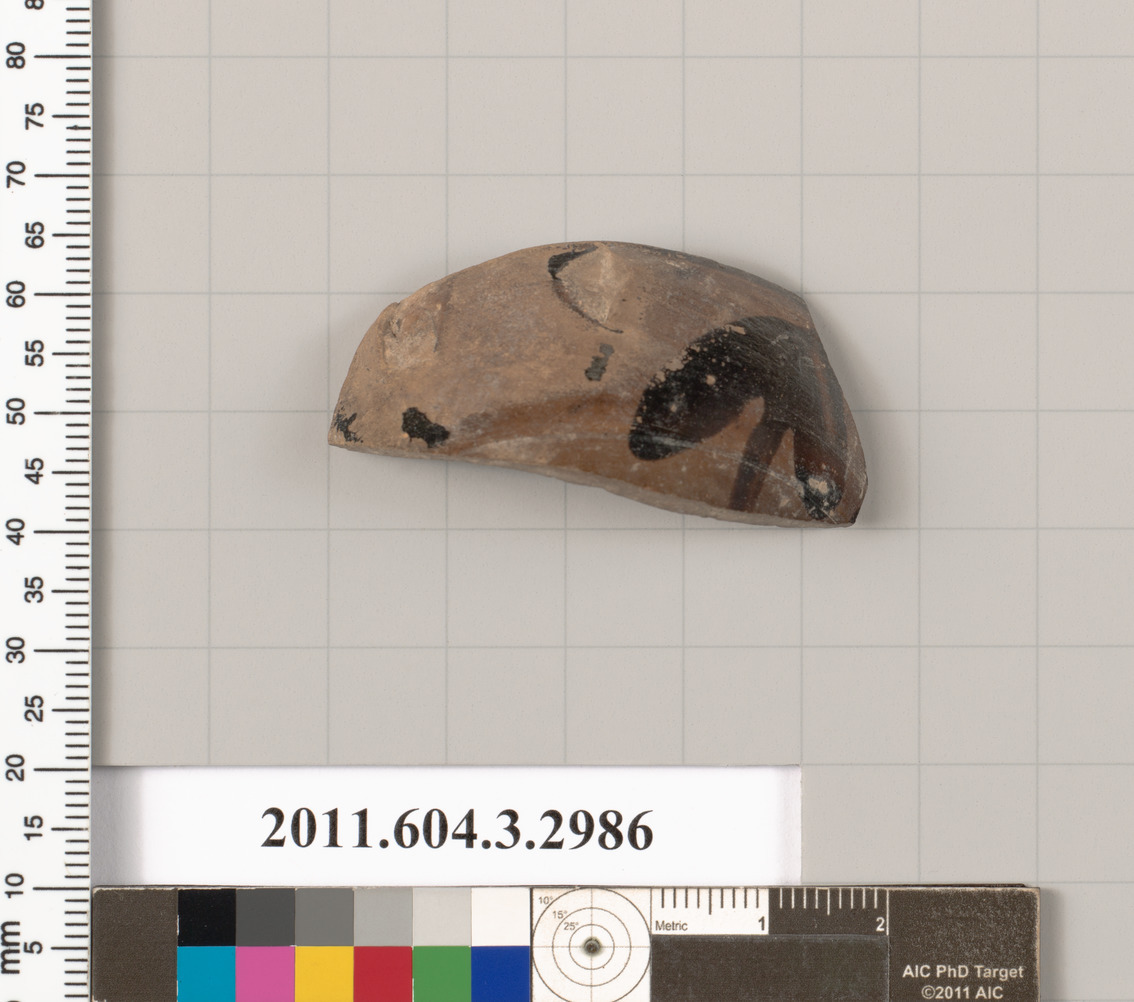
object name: skyphos fragment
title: Terracotta fragment of a skyphos (deep drinking cup)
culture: greek, attic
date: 600-401 BCE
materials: terracotta